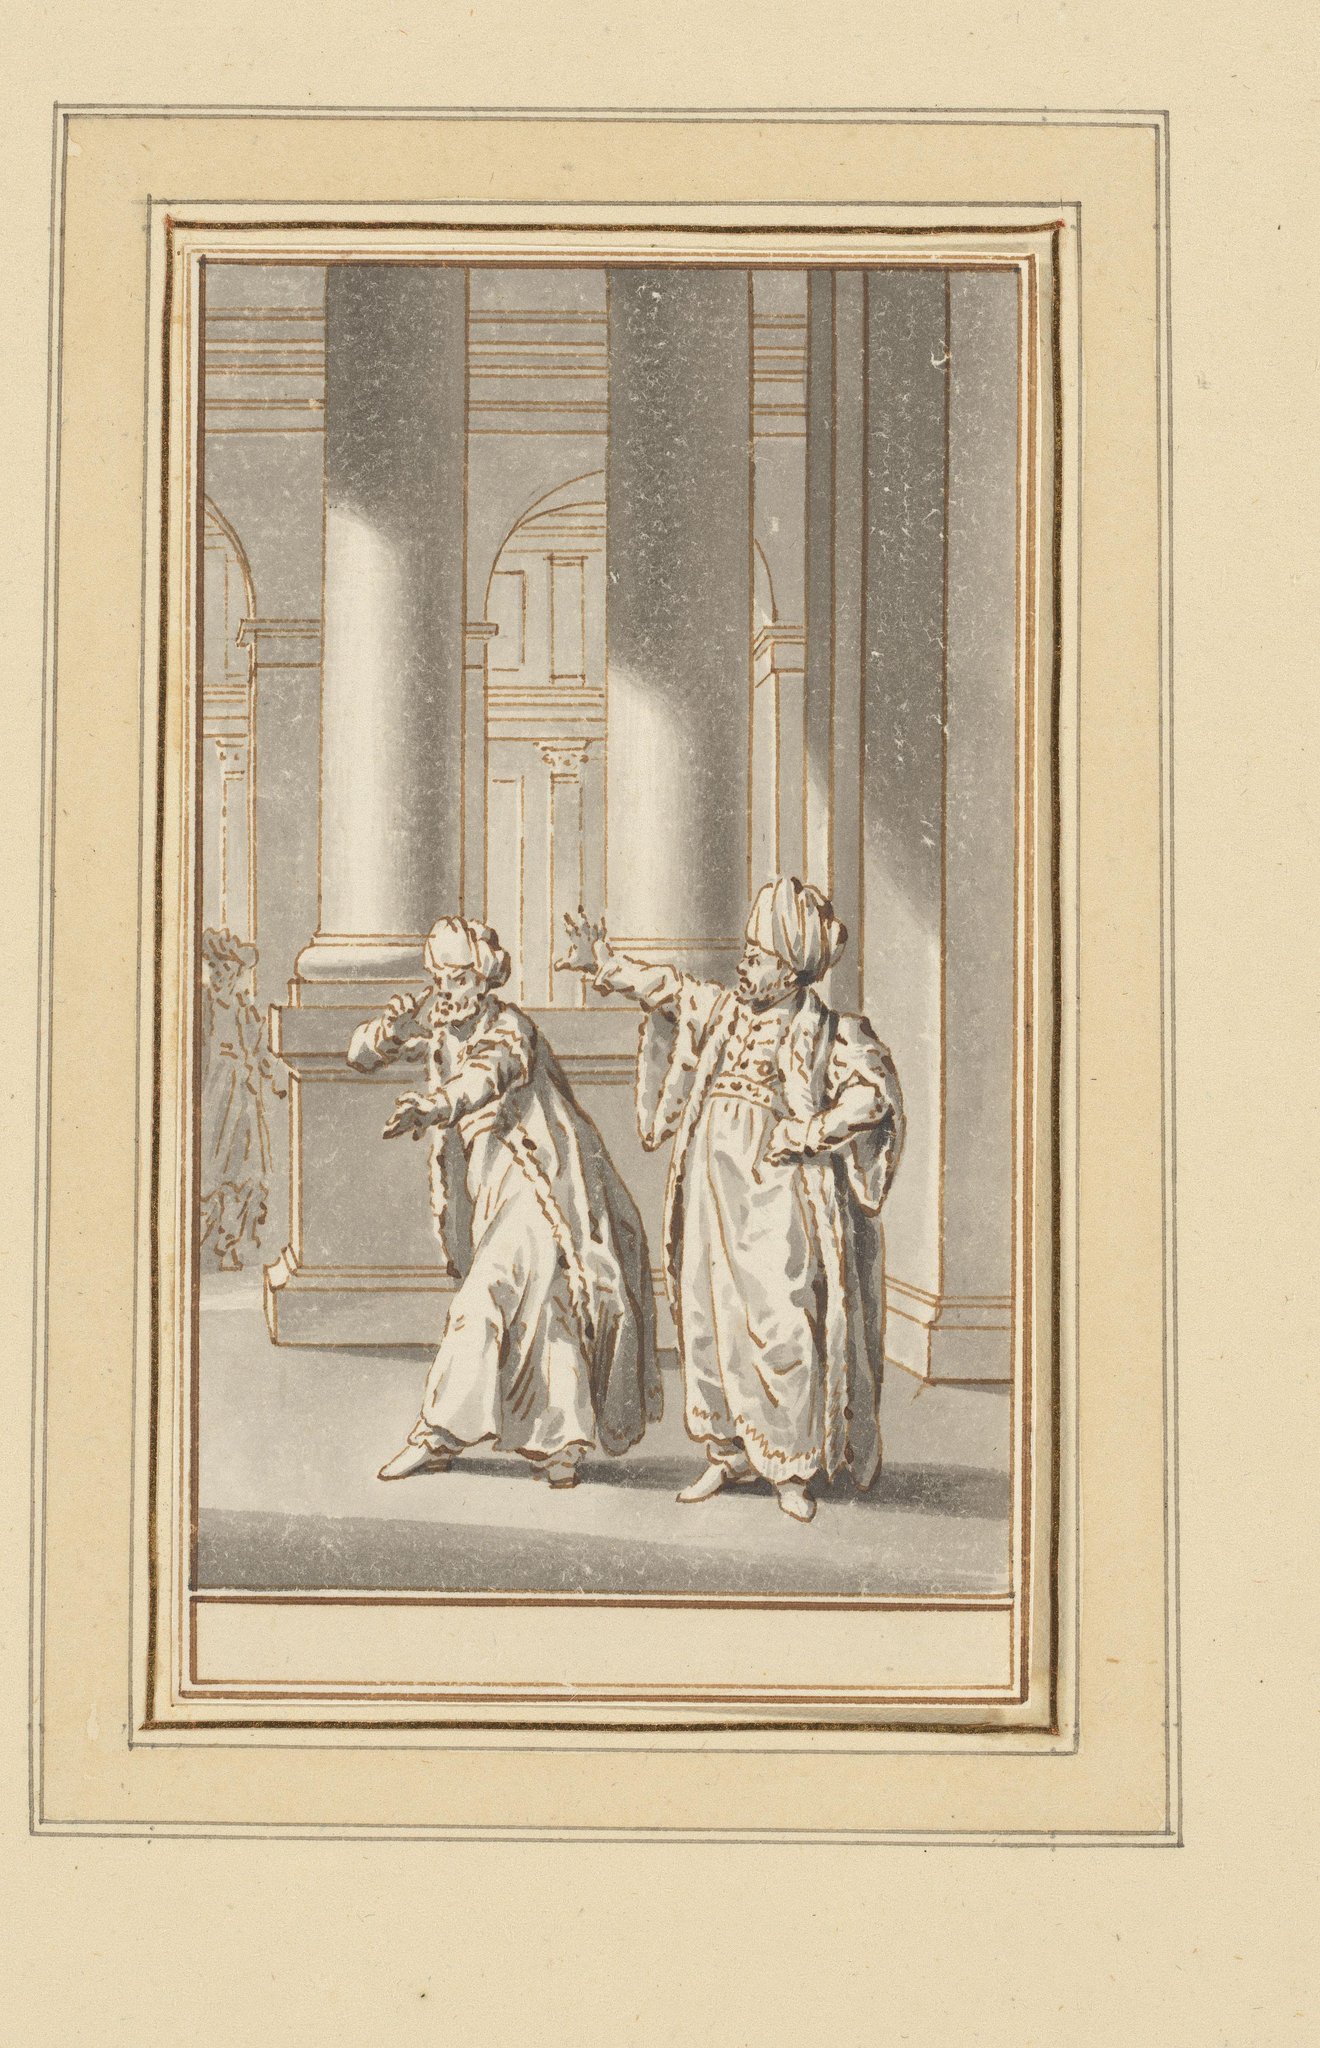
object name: boekillustratie ontwerp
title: Mohammed en Seid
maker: cornelis buys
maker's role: draughtsman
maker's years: 1746-1826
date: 1780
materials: cardboard, paper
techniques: brush, pen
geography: amsterdam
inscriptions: number: ‘N. 57’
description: Een van de vijf ontwerpen voor illustraties bij de vijf bedrijven van Voltaire's 'Le Fanatisme, ou le Prophete, Tragedie', vertaald door A. Hartsen, Amsterdam 1770, en Amsterdam 1783, op opzetkarton van Cornelis Ploos van Amstel.